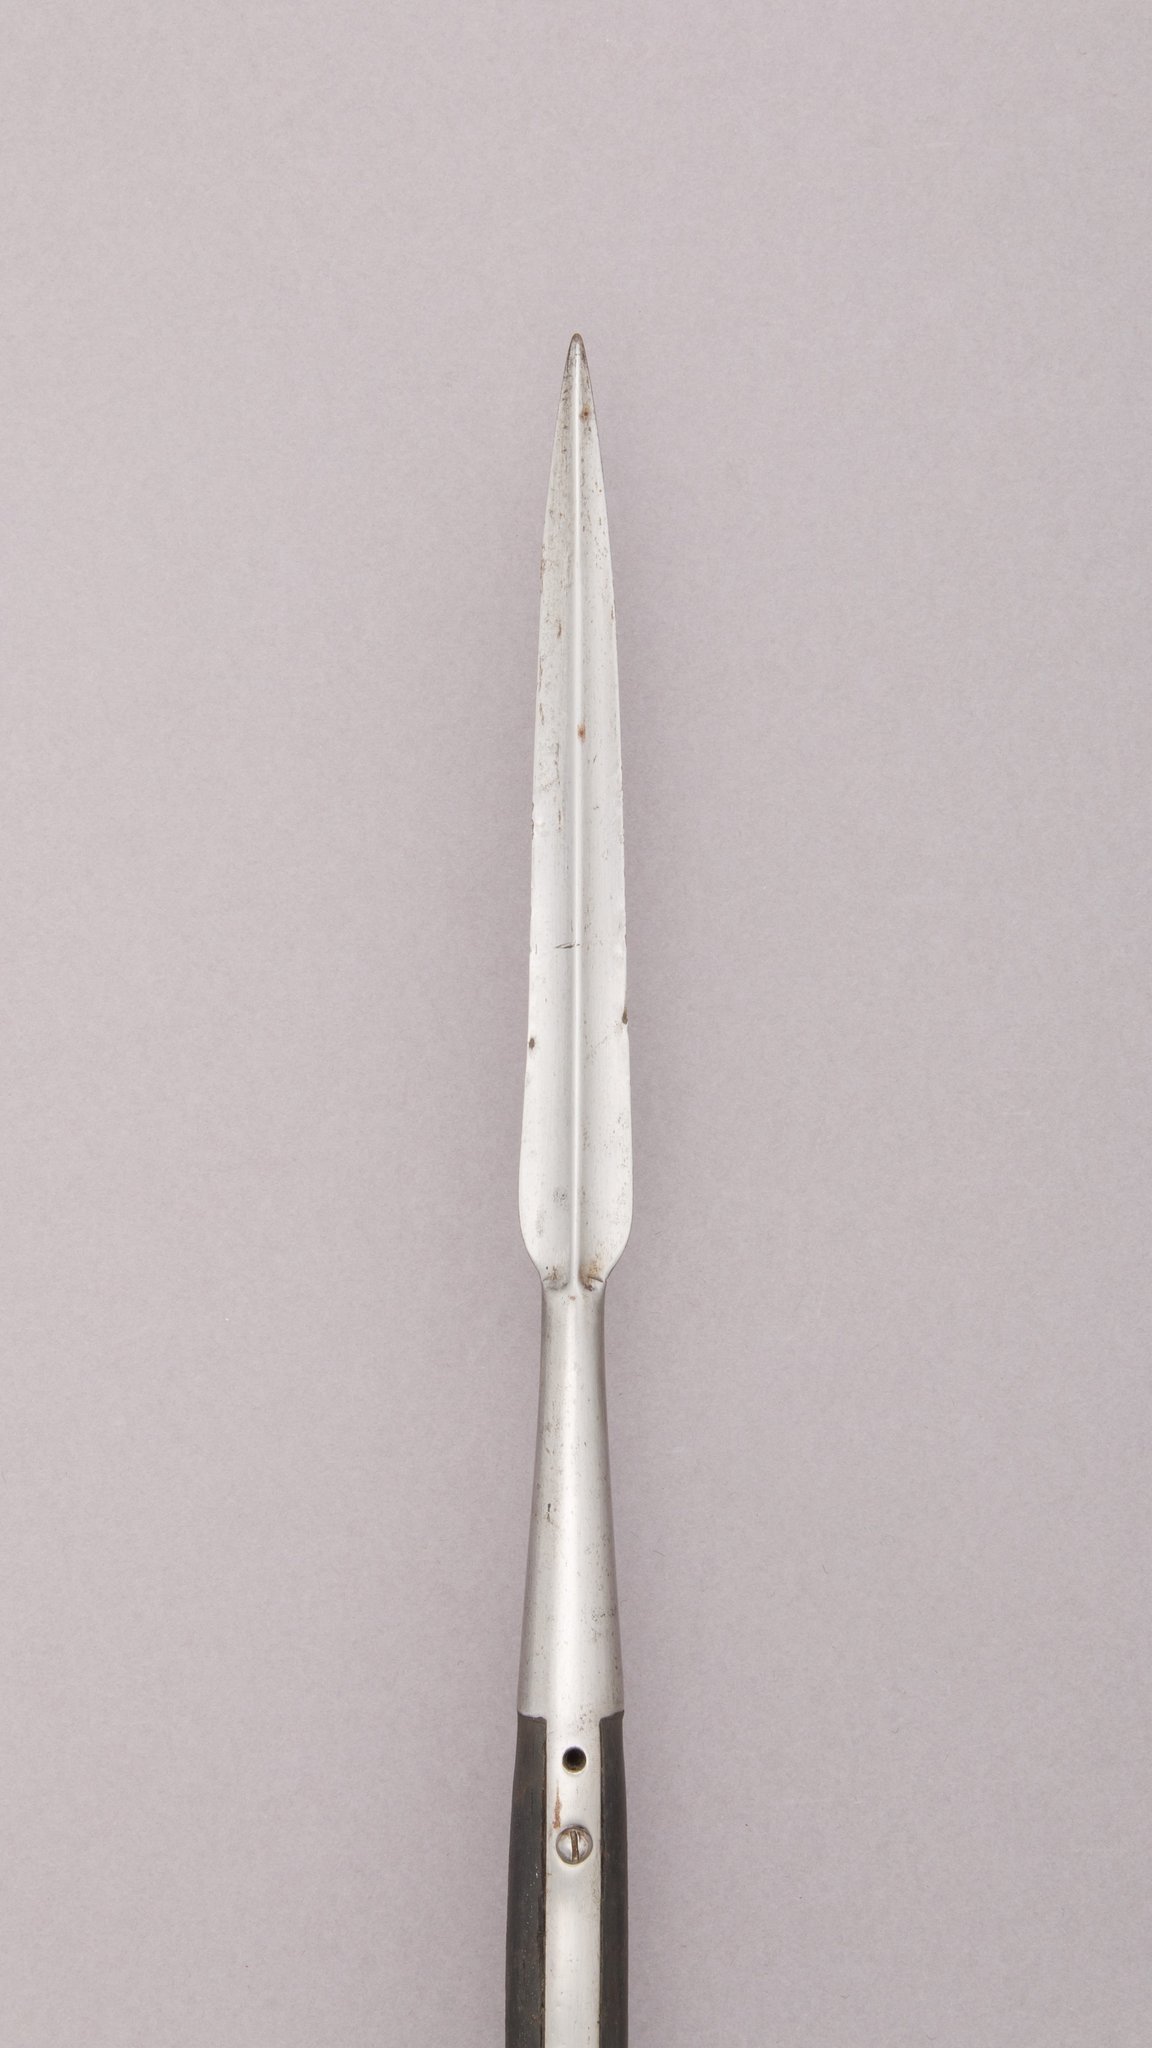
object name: lance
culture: german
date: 1701-1800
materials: steel, wood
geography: germany